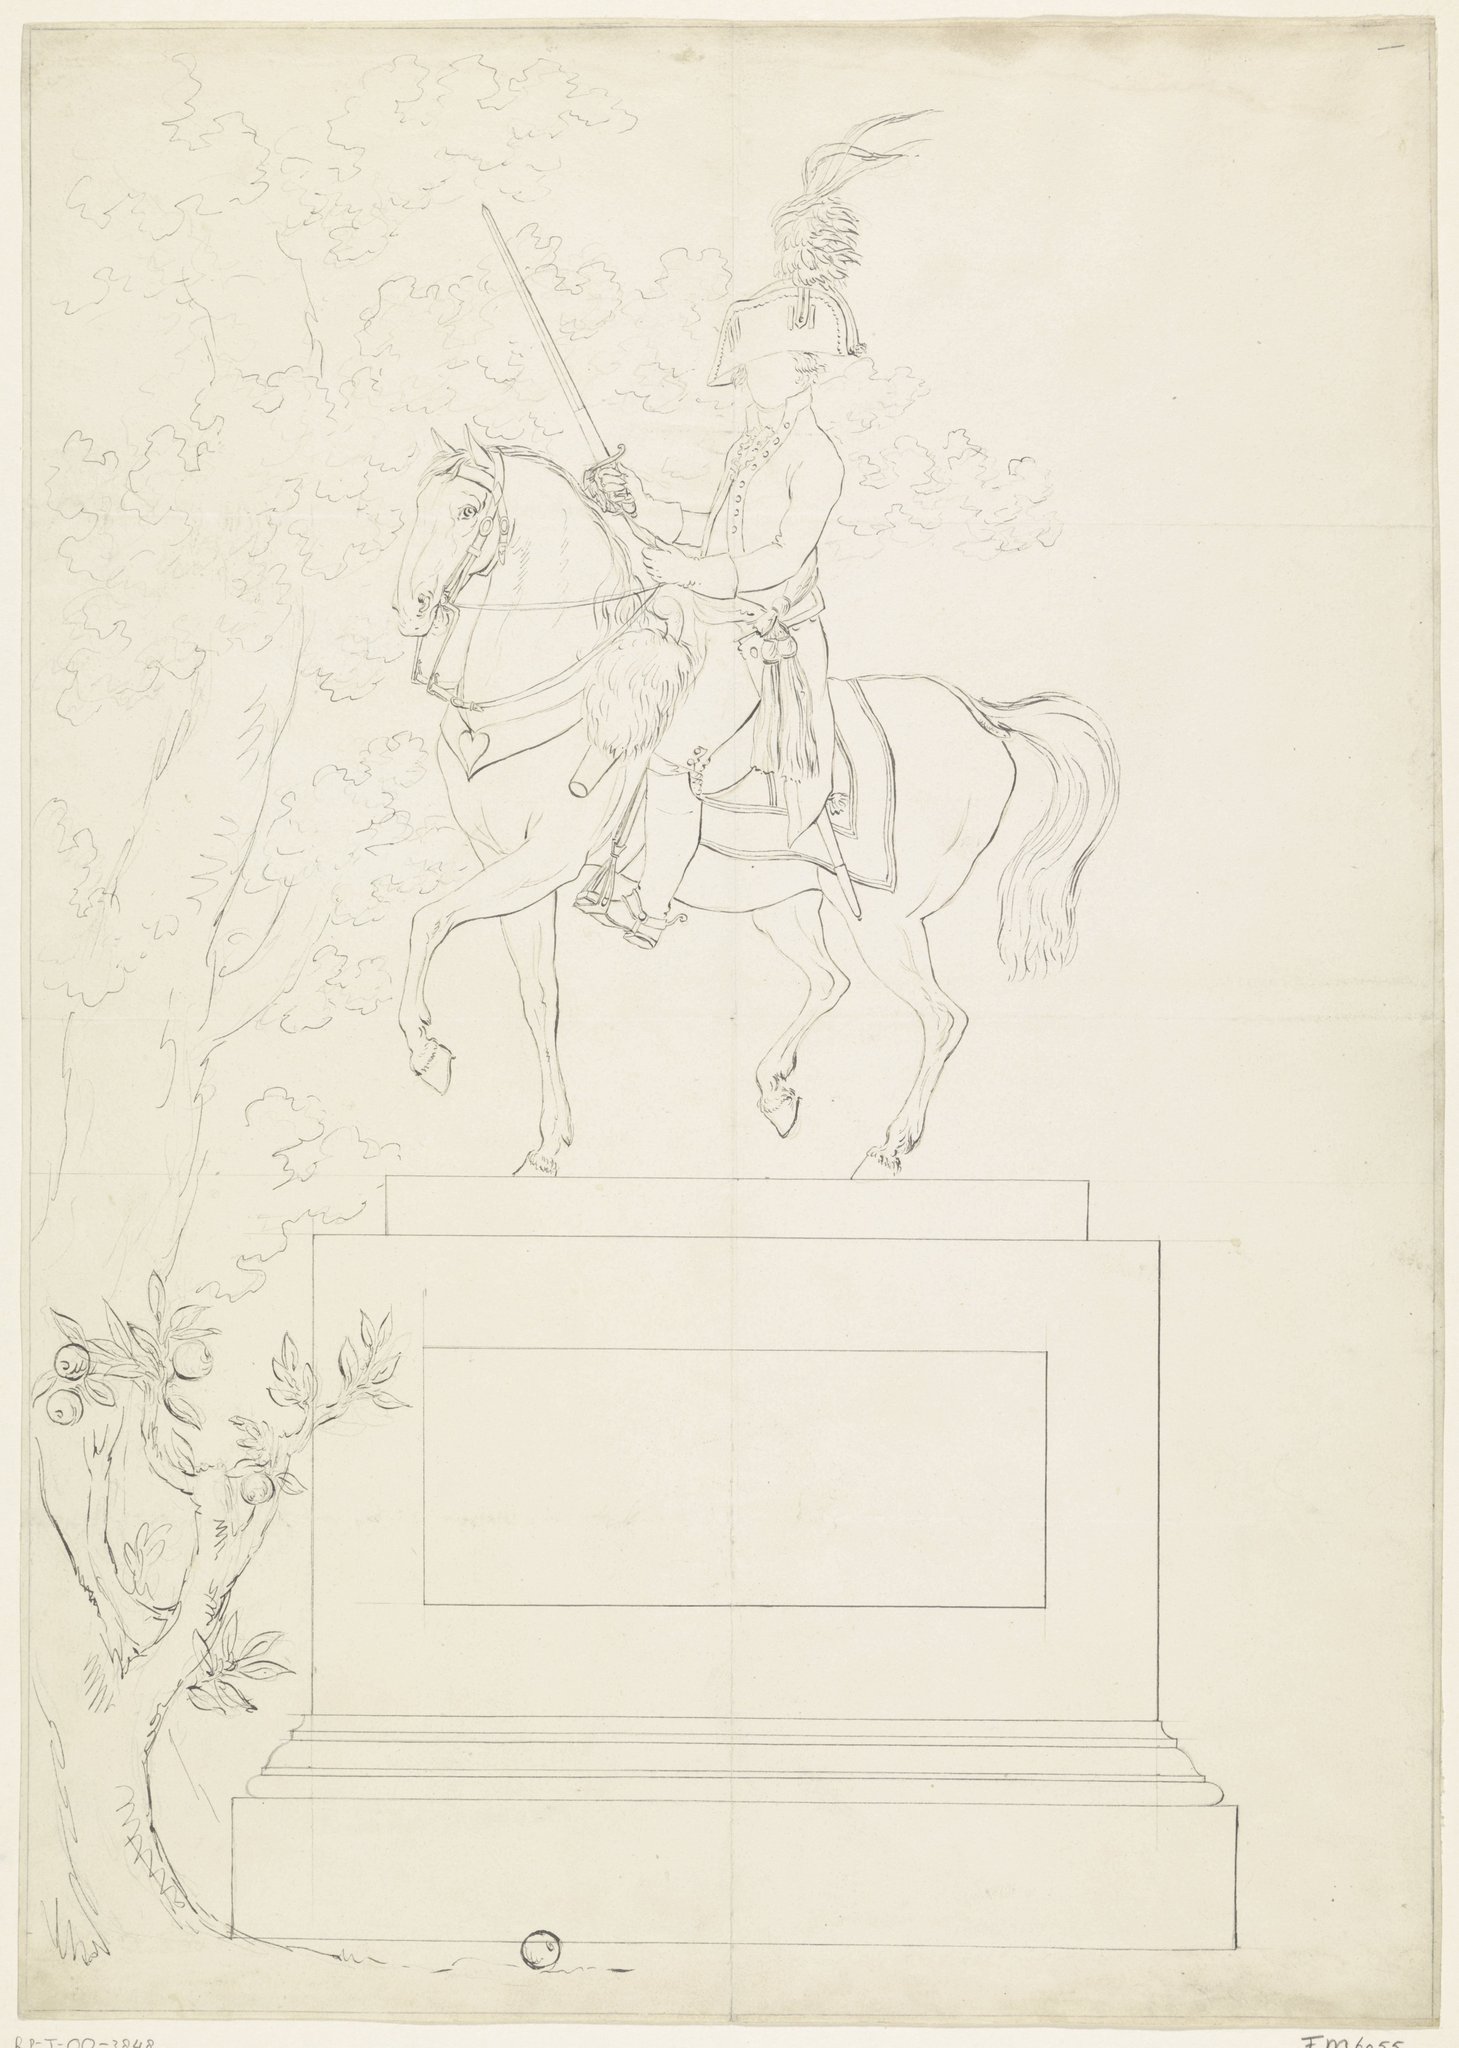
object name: drawing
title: Ruiterstandbeeld van de prins van Oranje, 1815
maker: Anonymous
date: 1815-1820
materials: ink, paper, pencil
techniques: pen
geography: netherlands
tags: the hague, william ii of the netherlands, equestrian statue, waterloo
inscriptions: collector's mark: Lugt 2228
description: Ruiterstandbeeld van de prins van Oranje, als overwinnaar en bevrijder van Nederland, naar aanleiding van zijn heldenrol tijdens de Slag bij Waterloo op 18 juni 1815. De prins te paard, met getrokken zwaard in de rechterhand, het gezicht nog oningevuld. Links een Oranjeboom met vruchten, een oranjeappel is van de boom gevallen en ligt voor het voetstuk van het beeld.